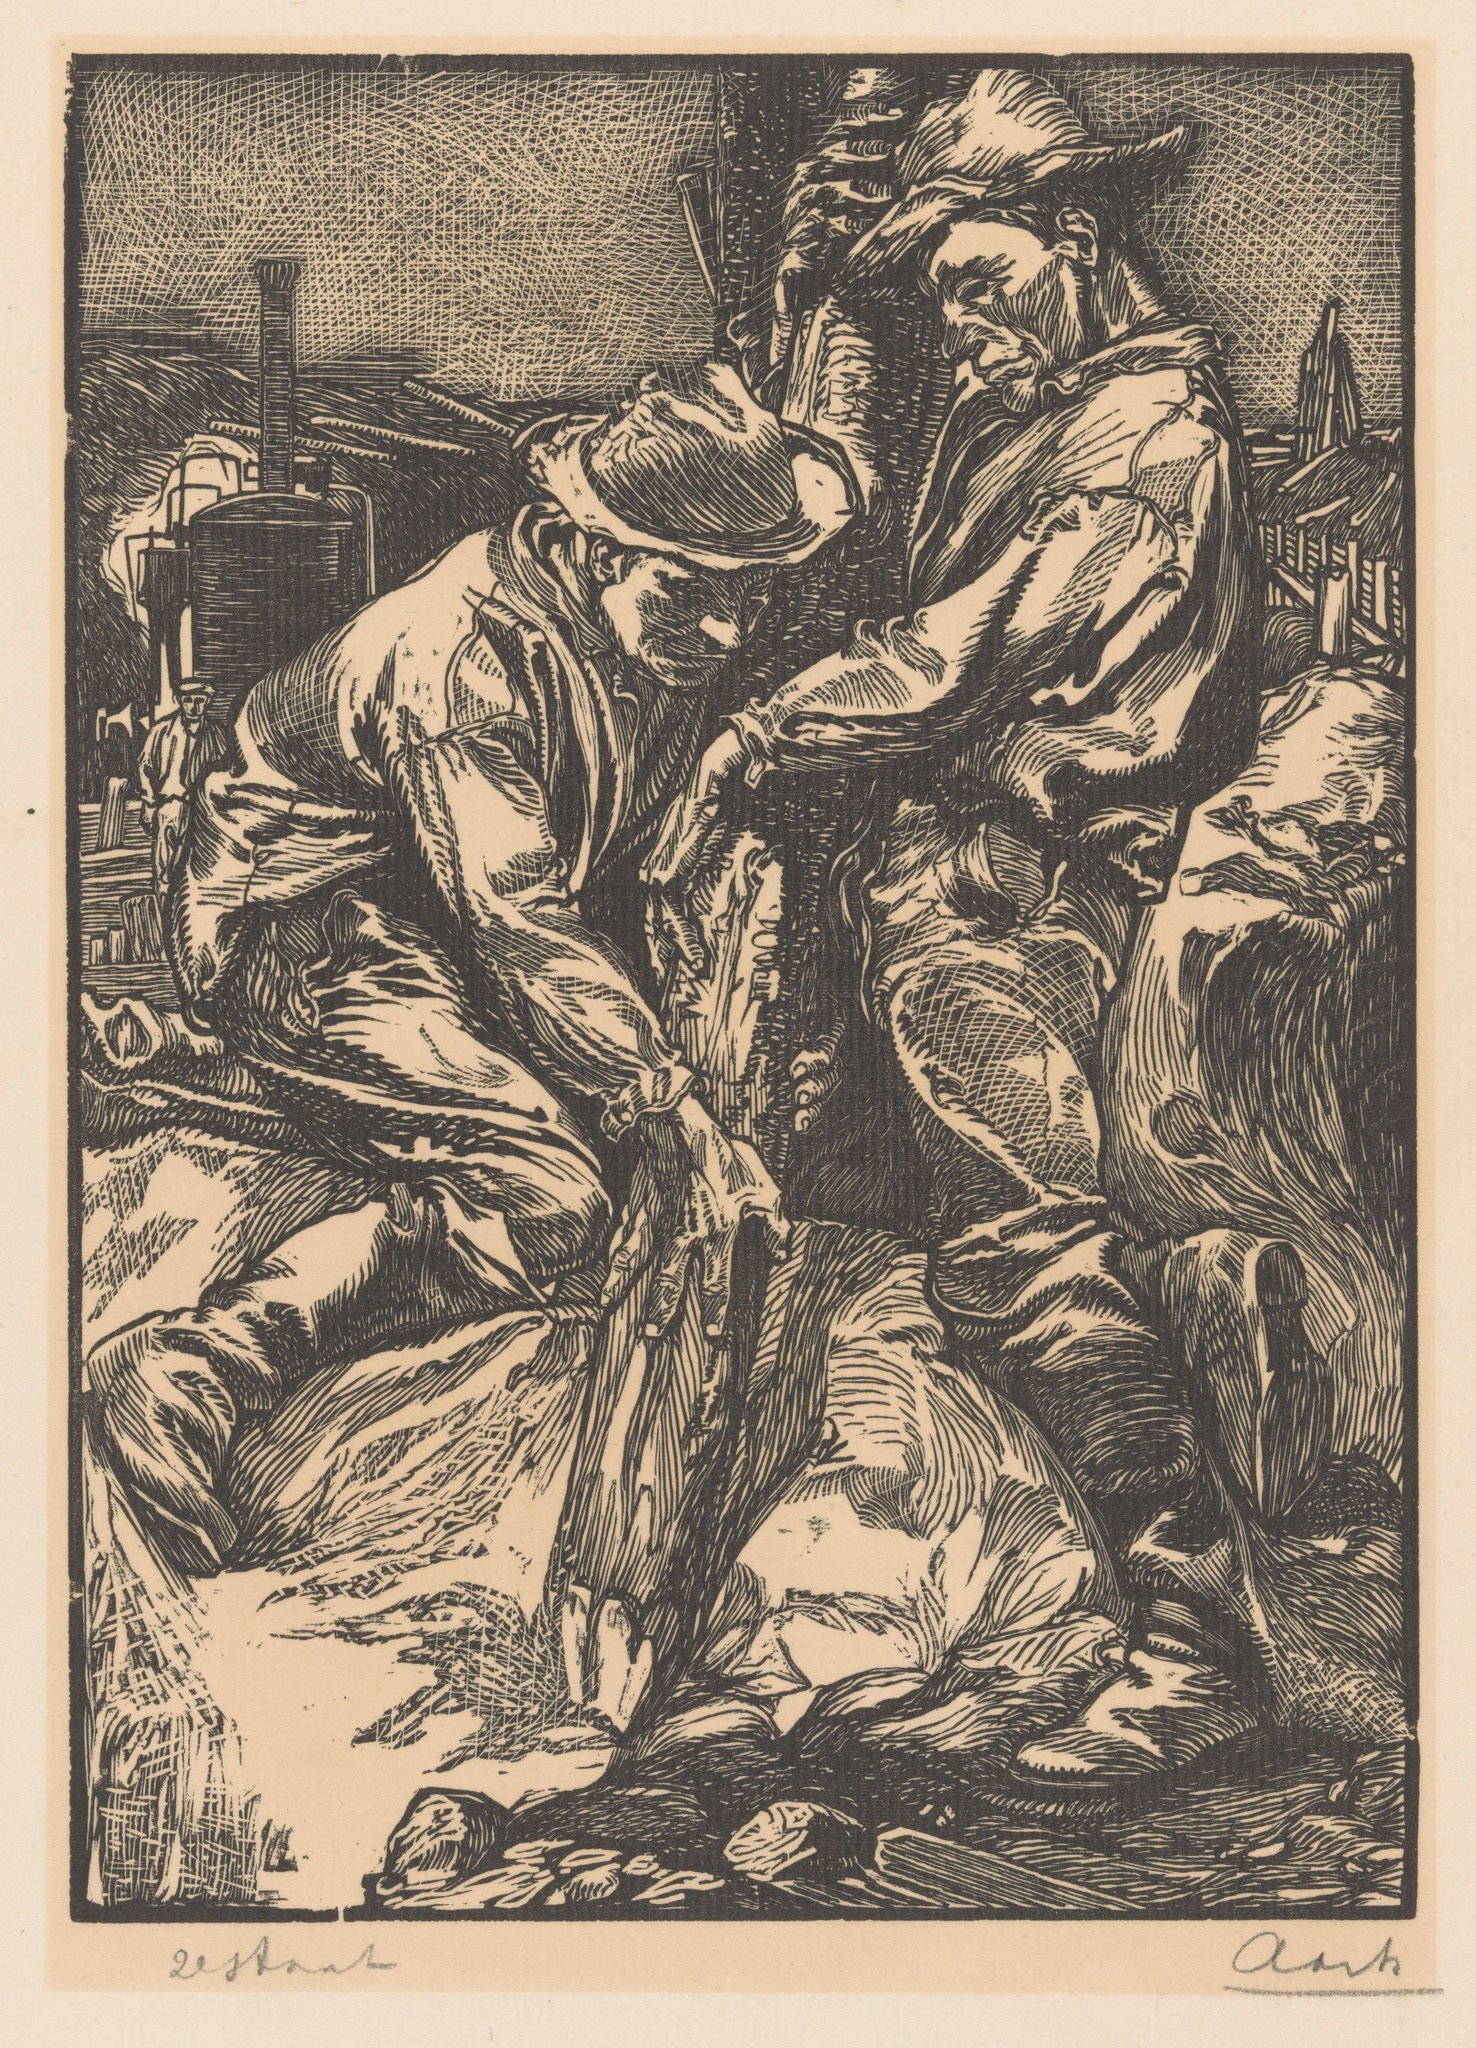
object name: print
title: Grondwerkers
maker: johannes josephus aarts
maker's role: draughtsman, print maker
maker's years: 1871-1934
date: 1881-1934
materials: paper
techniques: woodcut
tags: ramming, driving piles (~ building activities), working class, labourers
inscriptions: collector's mark: Lugt 2166, collector's mark: Lugt 2760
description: Twee arbeiders plaatsen samen een paal in de grond. Ze dragen beiden een hoed. Linksachter hen een machine en een andere arbeider.